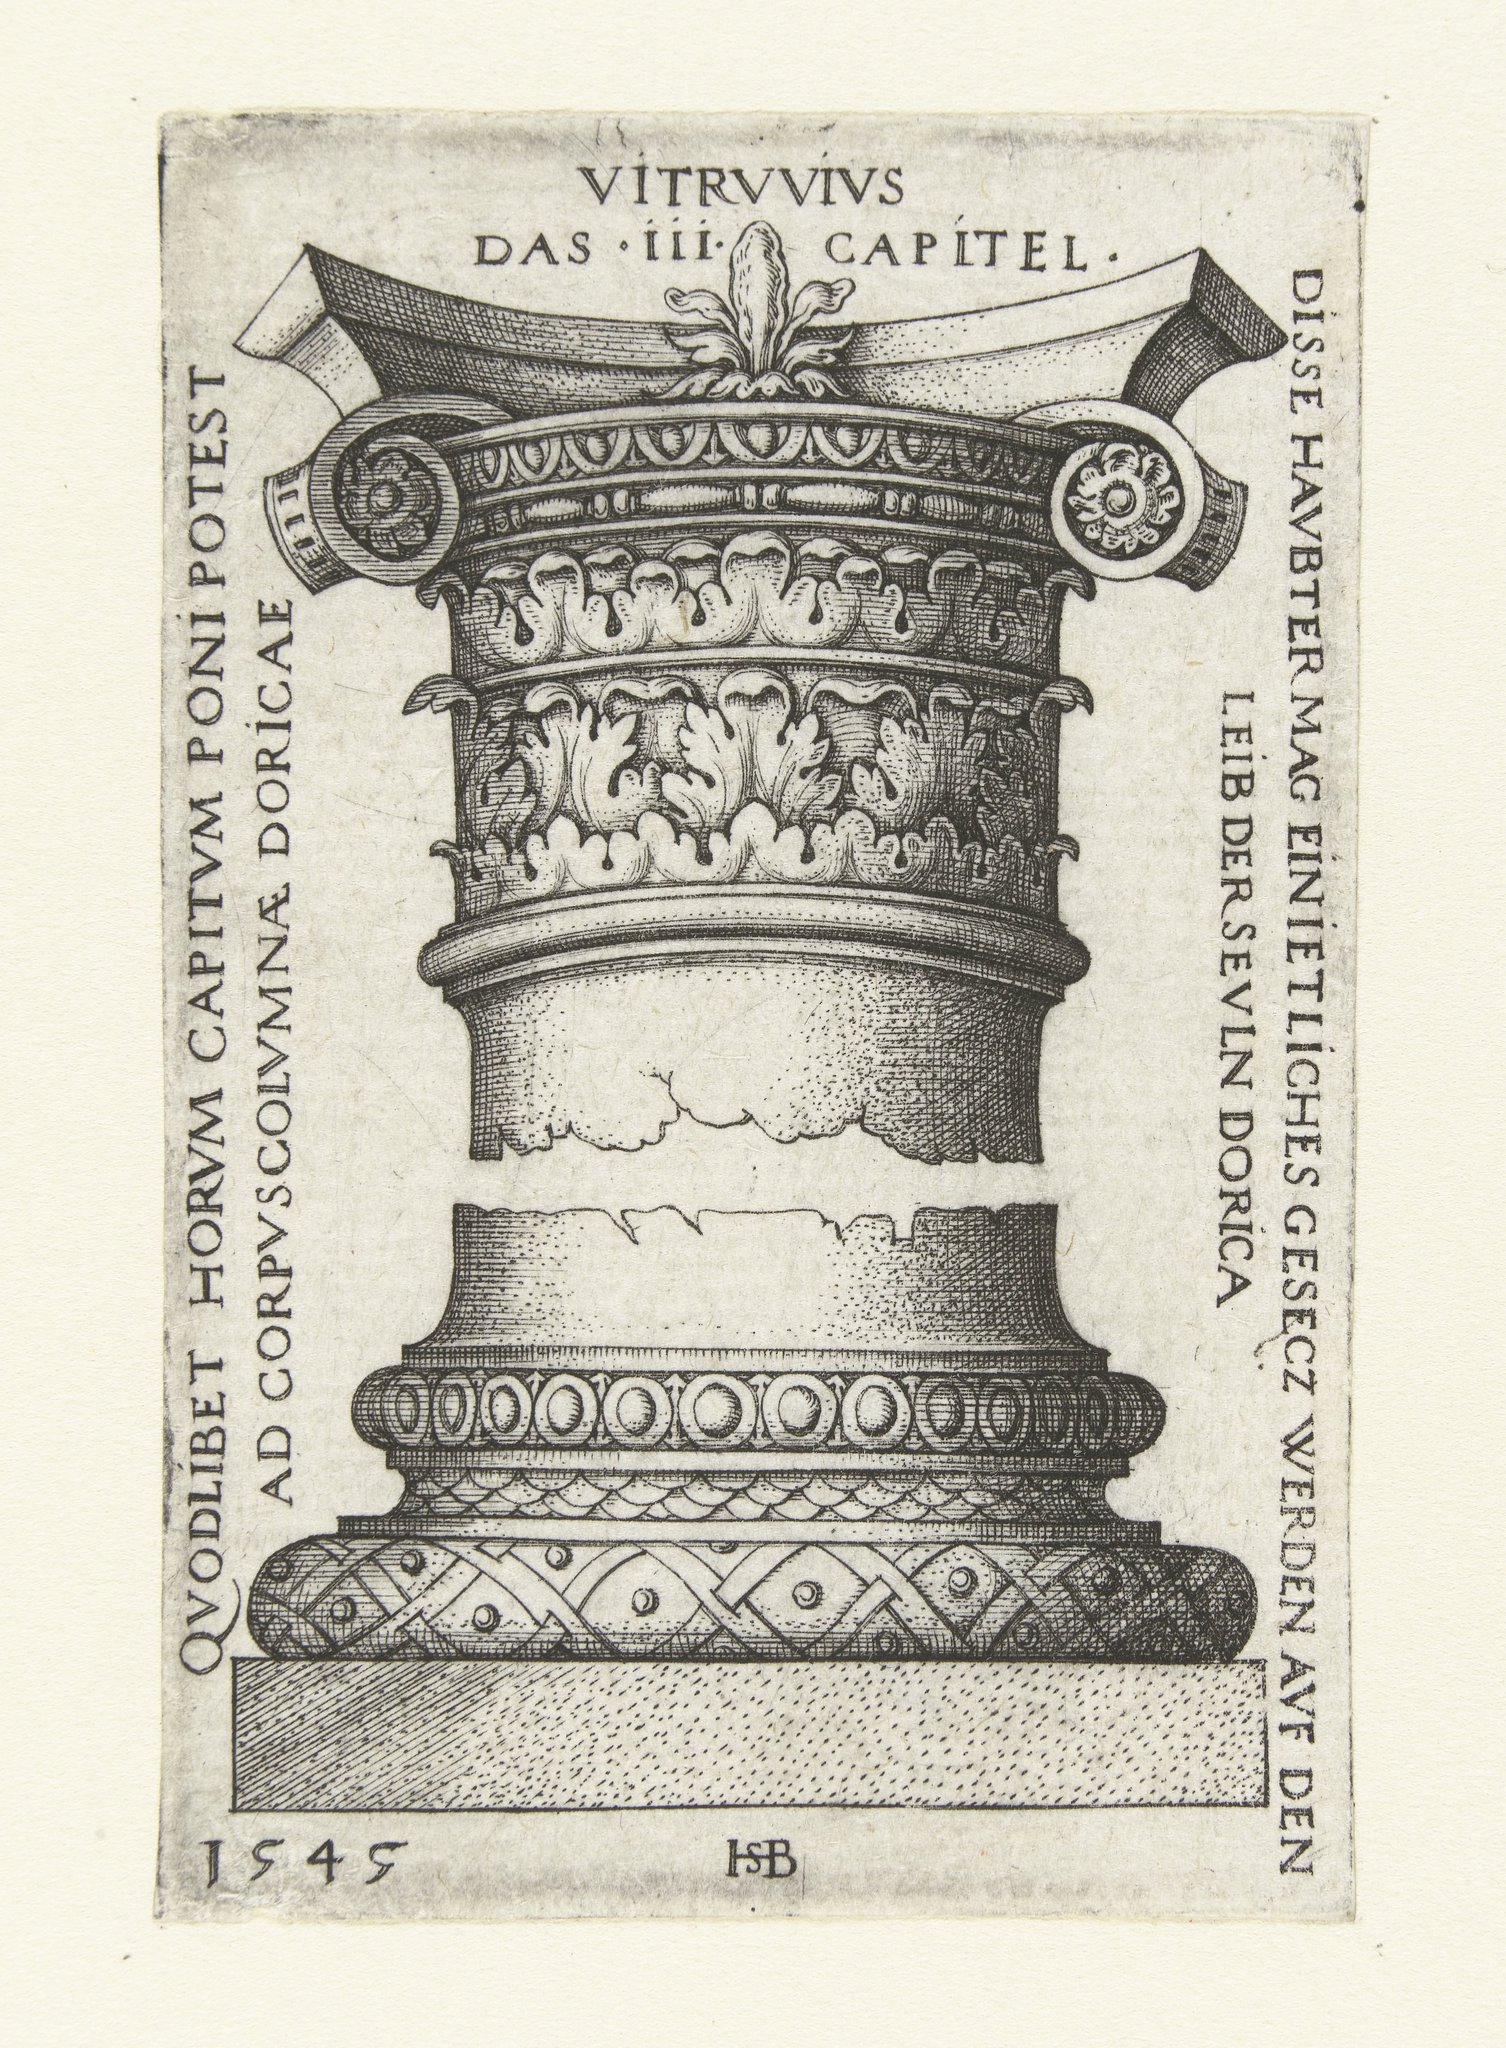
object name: ornament print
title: Vitrvvivs das III capital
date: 1510-1550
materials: paper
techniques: engraving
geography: germany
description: Het basement is gedecoreerd met een eierlijst, een rand met schubben en een rand met vlechtwerk. 1 blad van 4 bladen.